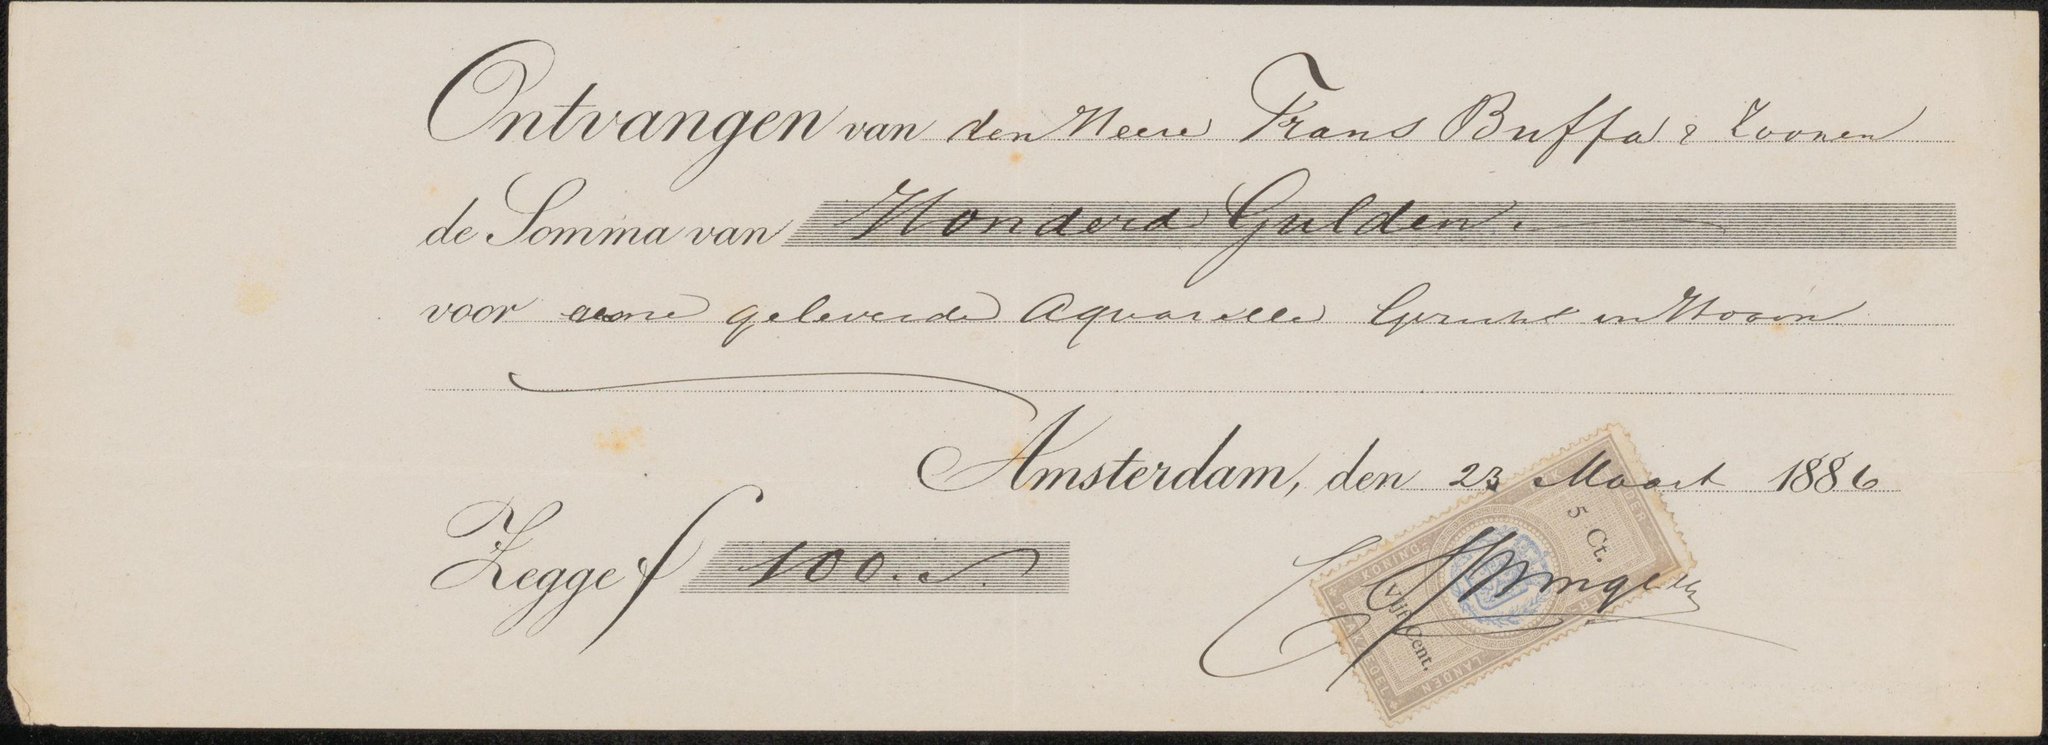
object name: ontvangstbewijs, kwitantie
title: Kwitantie voor Cornelis Springer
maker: cornelis springer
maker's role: draughtsman, painter, print maker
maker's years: 1817-1891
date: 1886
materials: ink, paper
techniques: pen, printing, writing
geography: amsterdam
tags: drawing, money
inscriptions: collector's mark: Lugt 2233